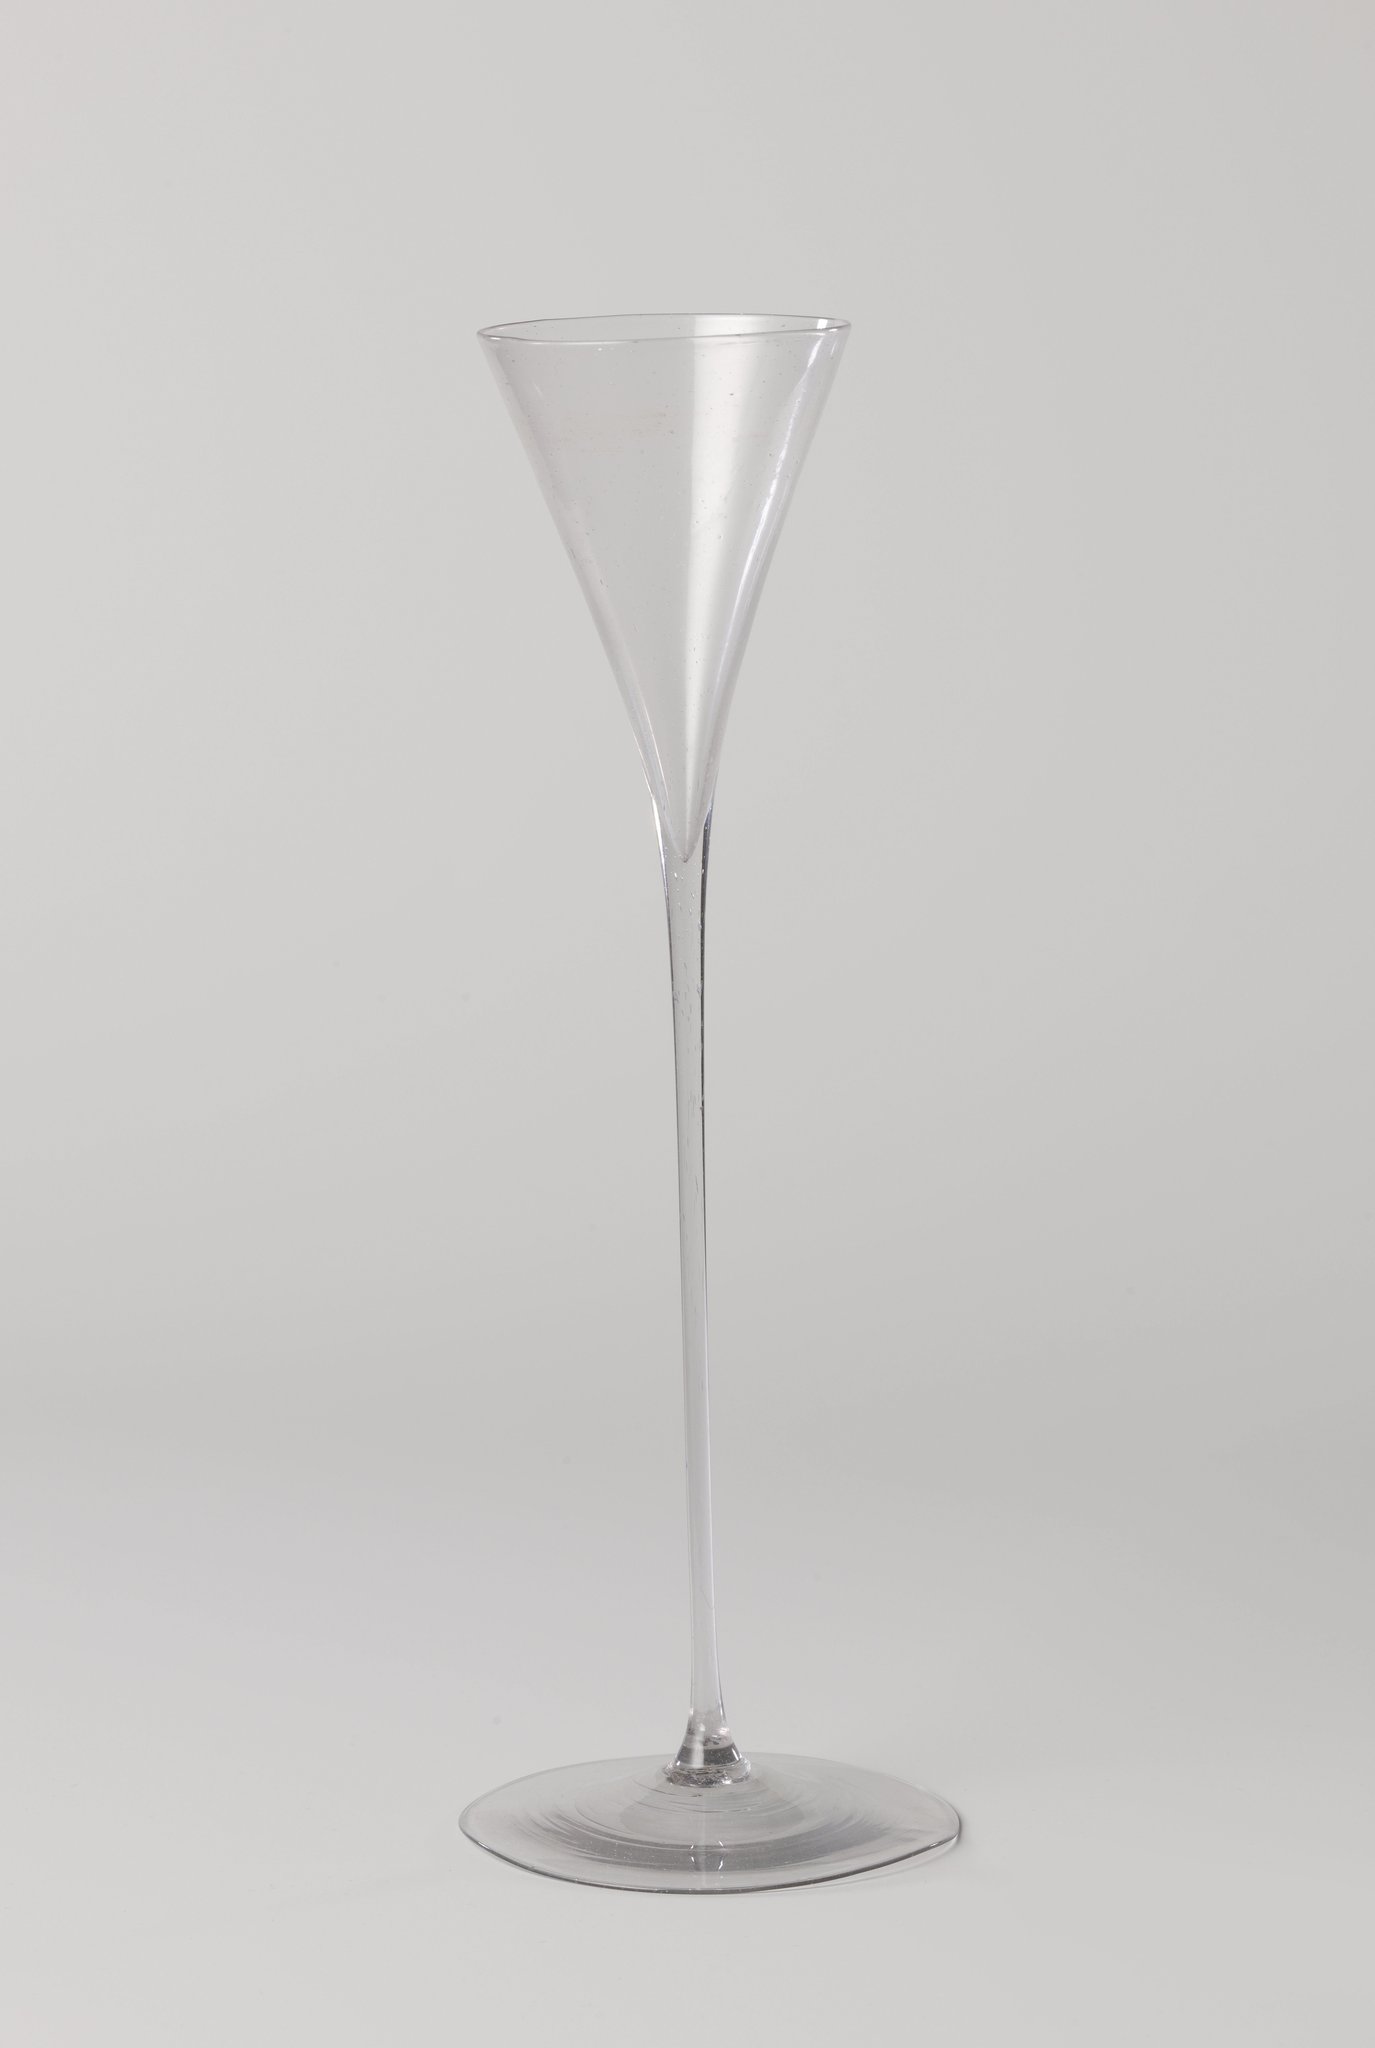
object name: pijpensteelglas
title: Pijpensteelglas met trechtervormige kelk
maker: Anonymous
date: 1700-1800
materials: glass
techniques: glassblowing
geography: southern netherlands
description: Pijpensteelglas op platte voet. Slanke hoge stam, overgaande in een trechtervormige, licht uitlopende kelk.